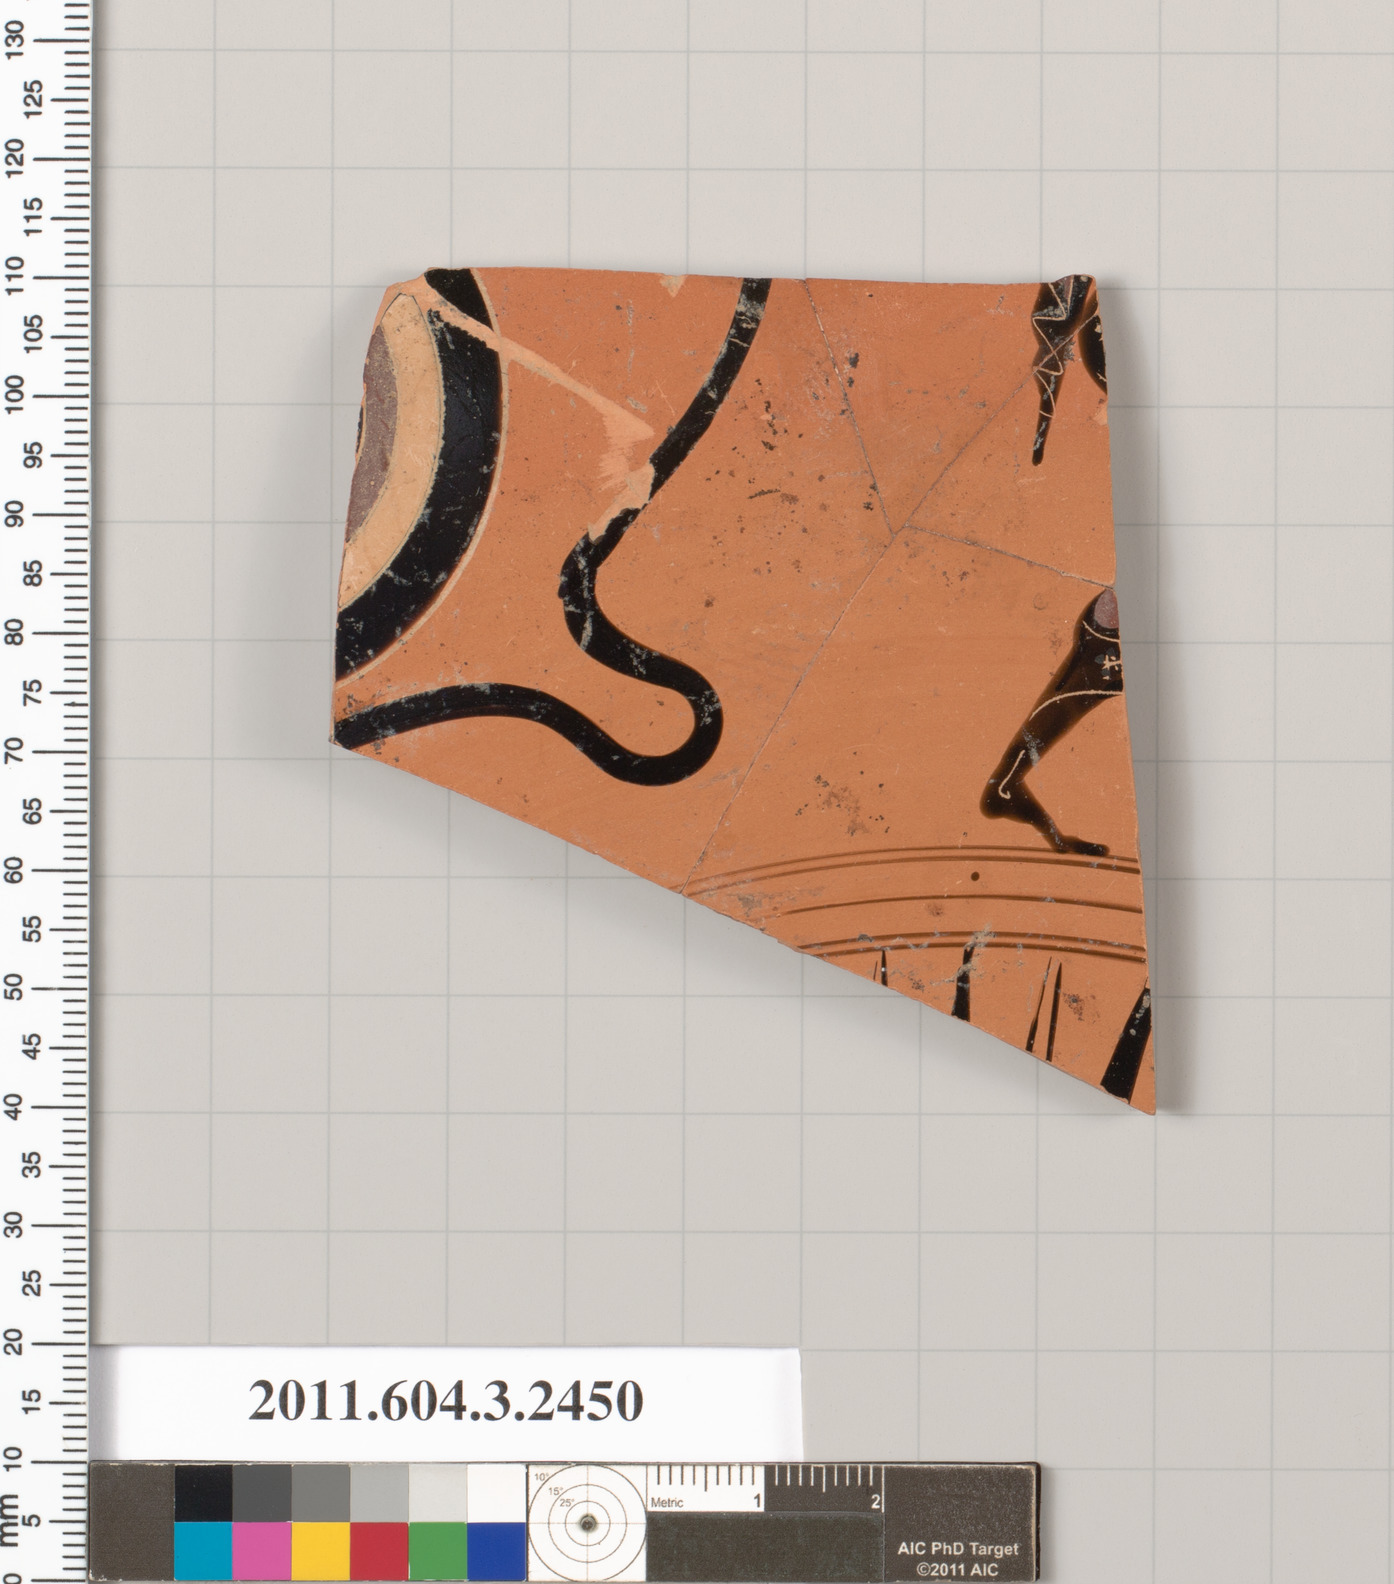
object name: kylix fragment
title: Terracotta fragment of a kylix: eye-cup (drinking cup)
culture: greek, attic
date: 530-510 BCE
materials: terracotta